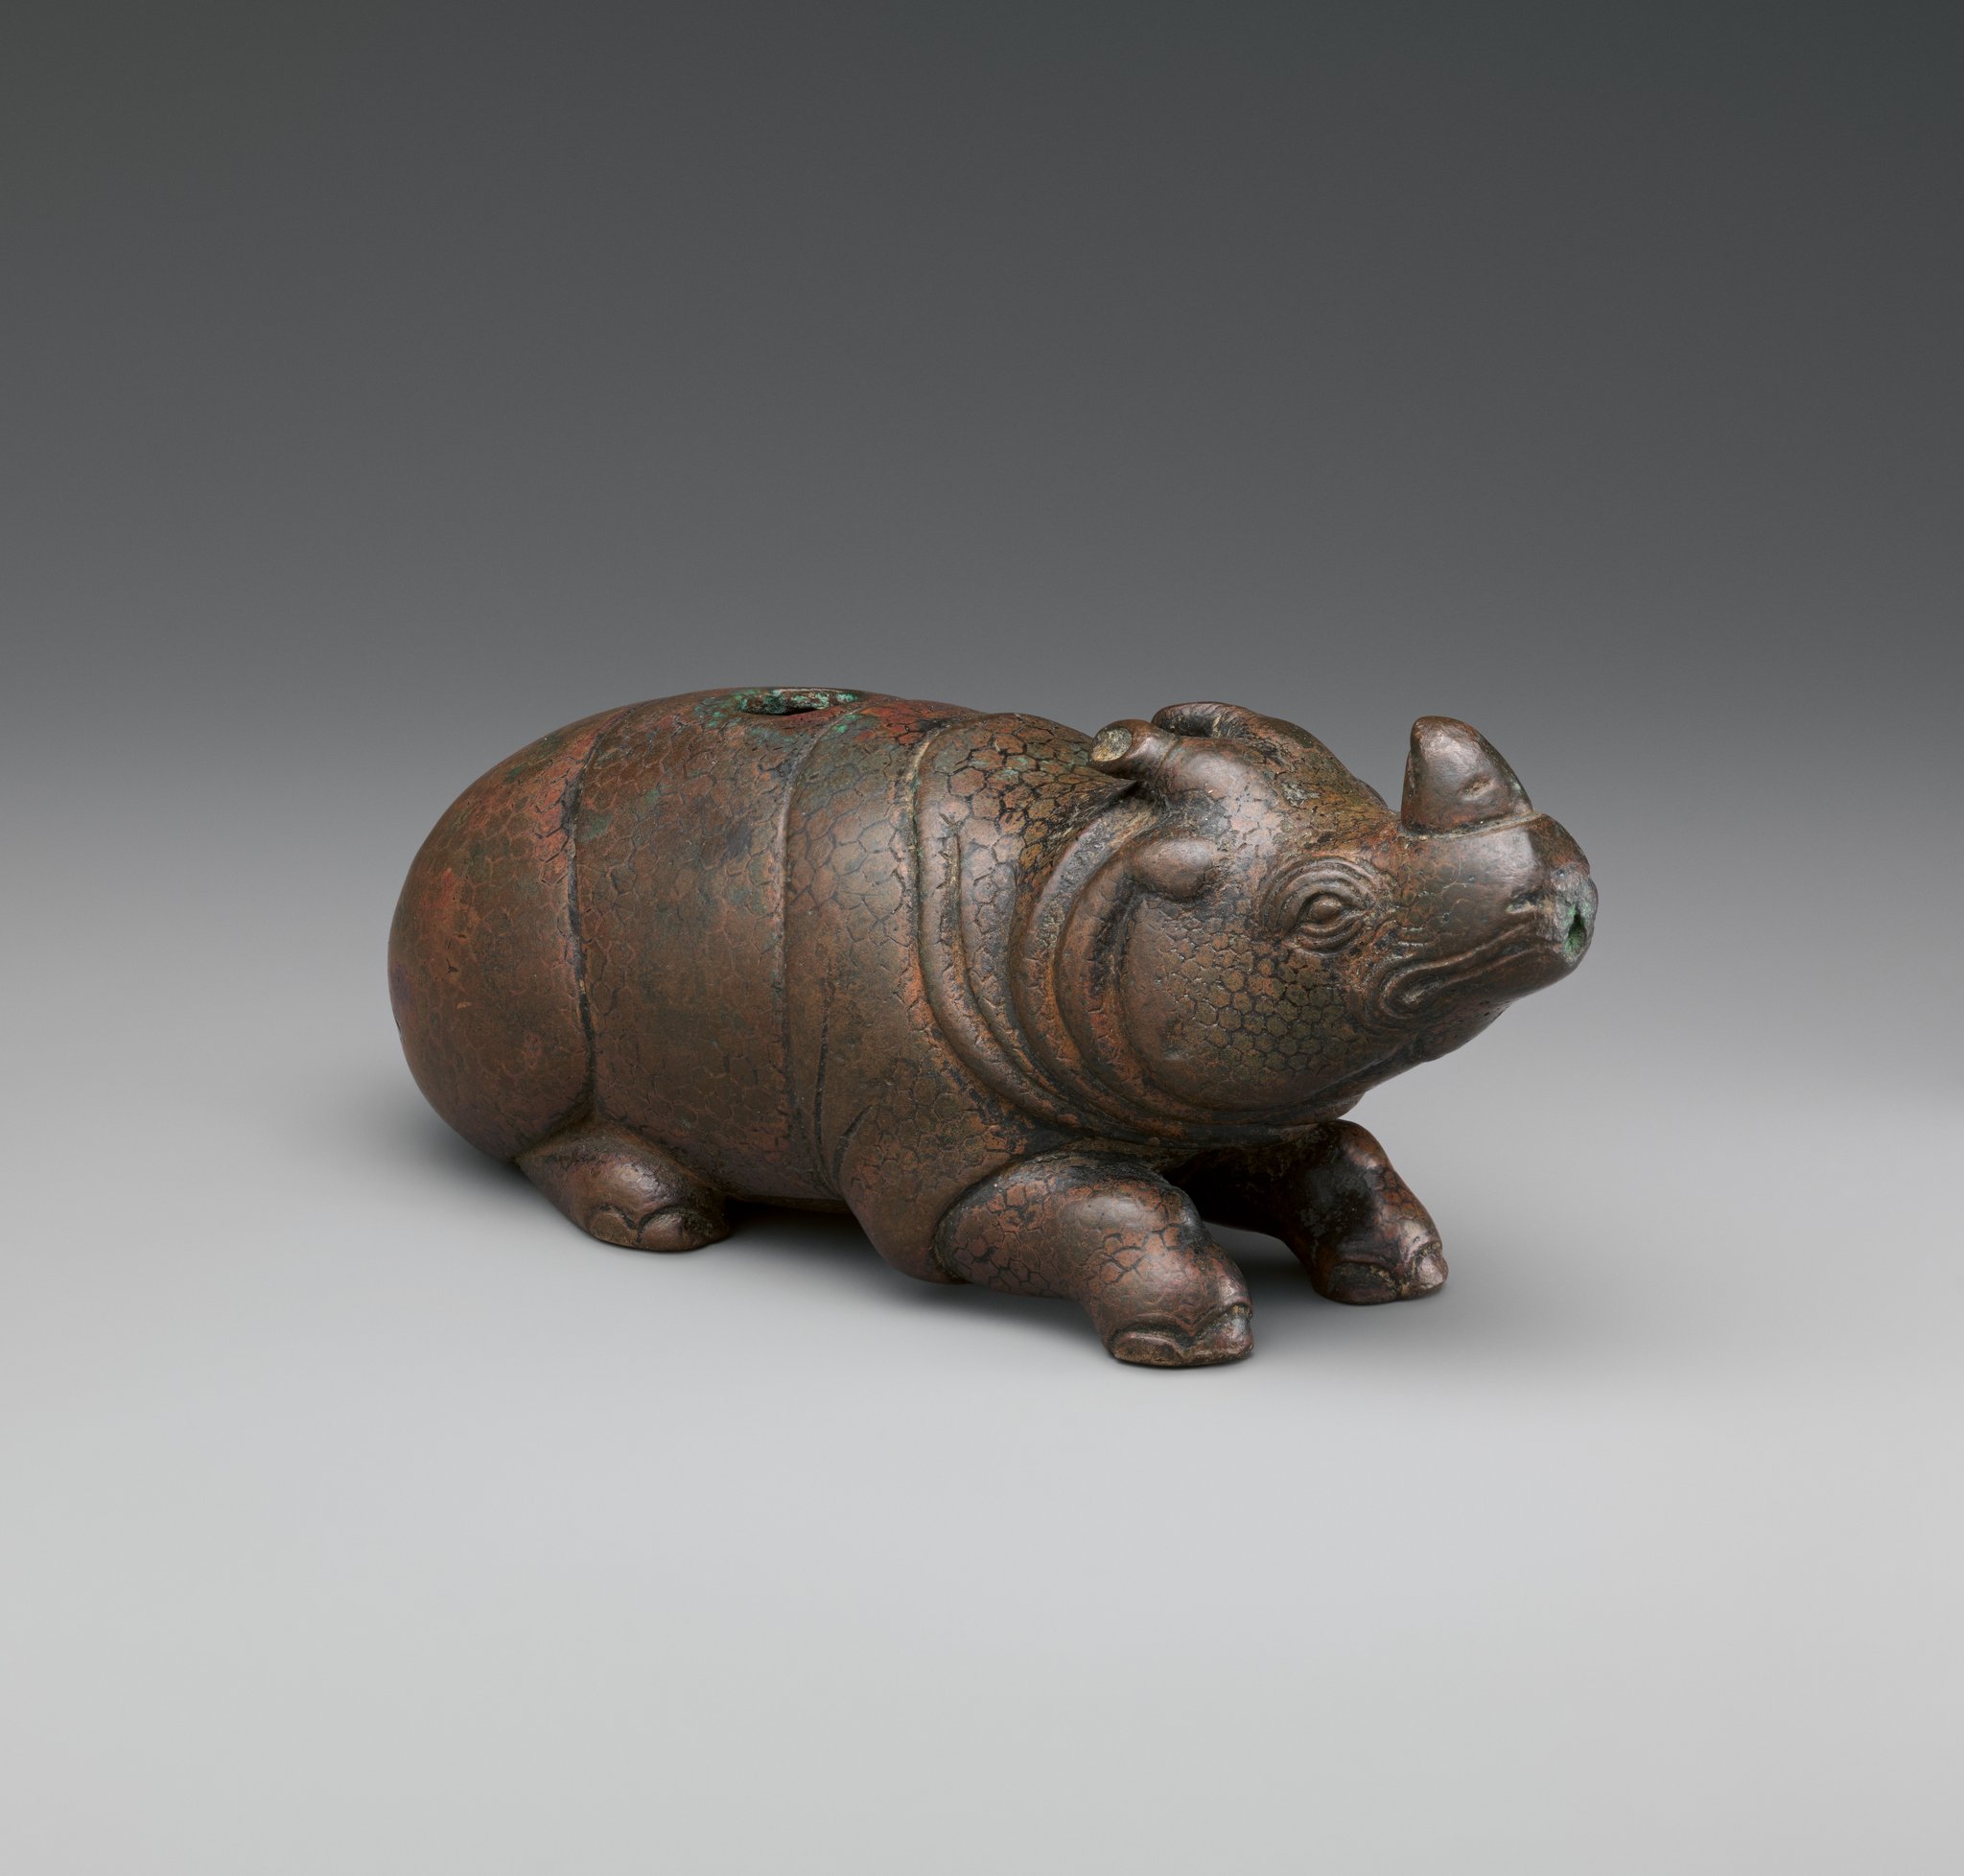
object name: water dropper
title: Water dropper in the shape of a rhinoceros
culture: chinese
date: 1401-1500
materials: copper alloy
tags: rhinoceros